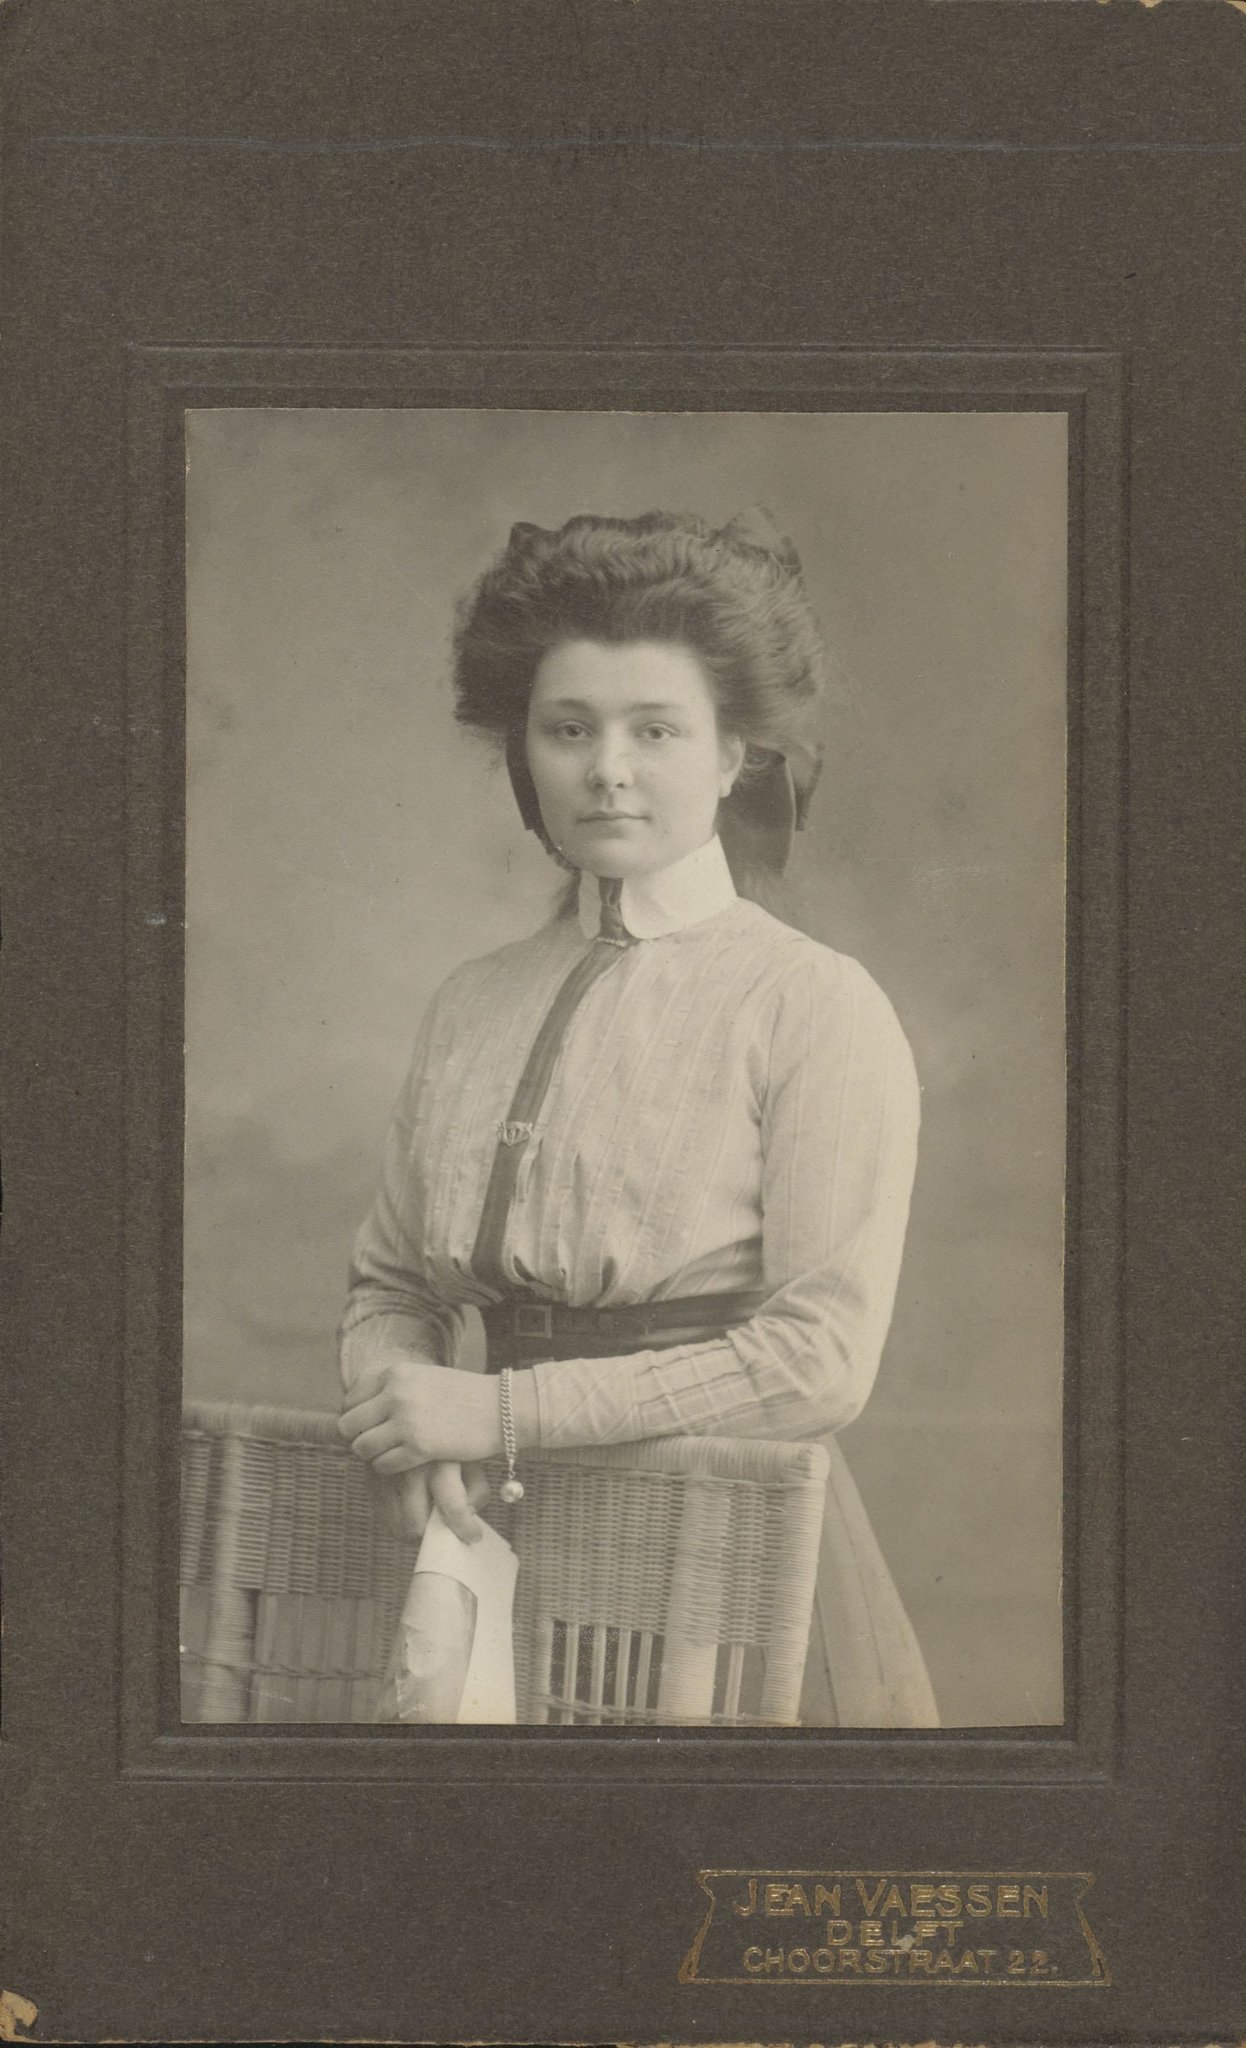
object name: carte de visite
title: Portret van een vrouw met opgestoken haar in een lange rok en blouse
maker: jean vaessen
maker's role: fotograaf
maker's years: 1868-1954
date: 1909-1911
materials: cardboard, paper, photographic support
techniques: daylight paper print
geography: delft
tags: clothing for the upper part of the body: blouse (+ women's clothes), skirt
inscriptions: address: ‘Delft Choorstraat 22’